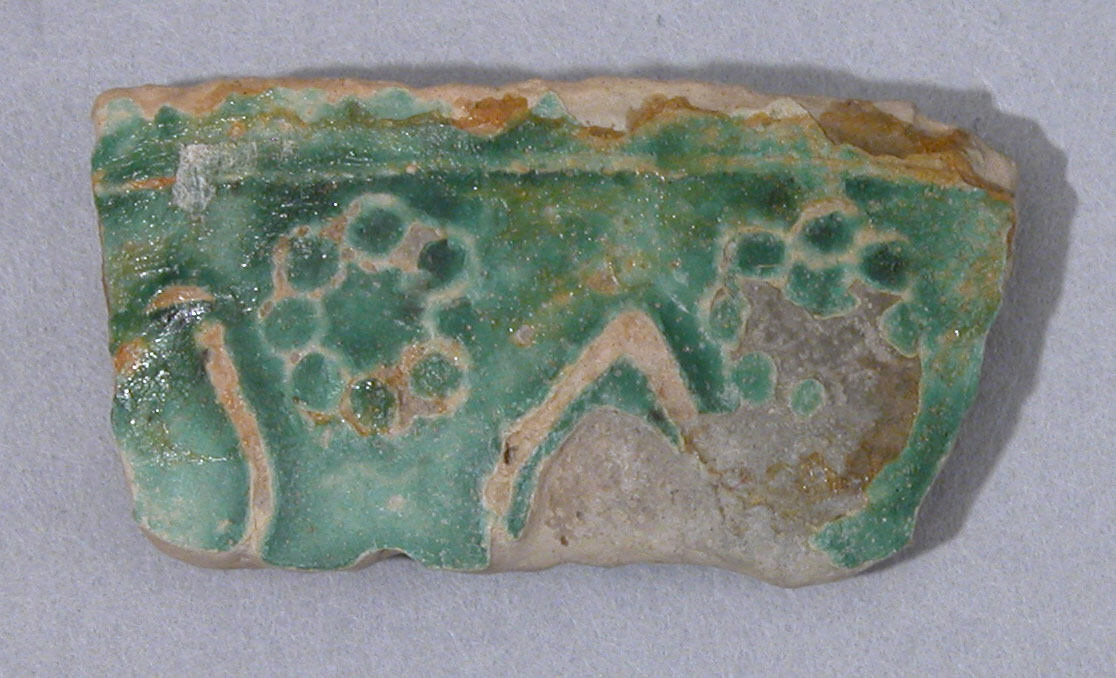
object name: fragment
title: Ceramic Fragment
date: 801-900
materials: earthenware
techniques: glazing, molding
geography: saudi arabia